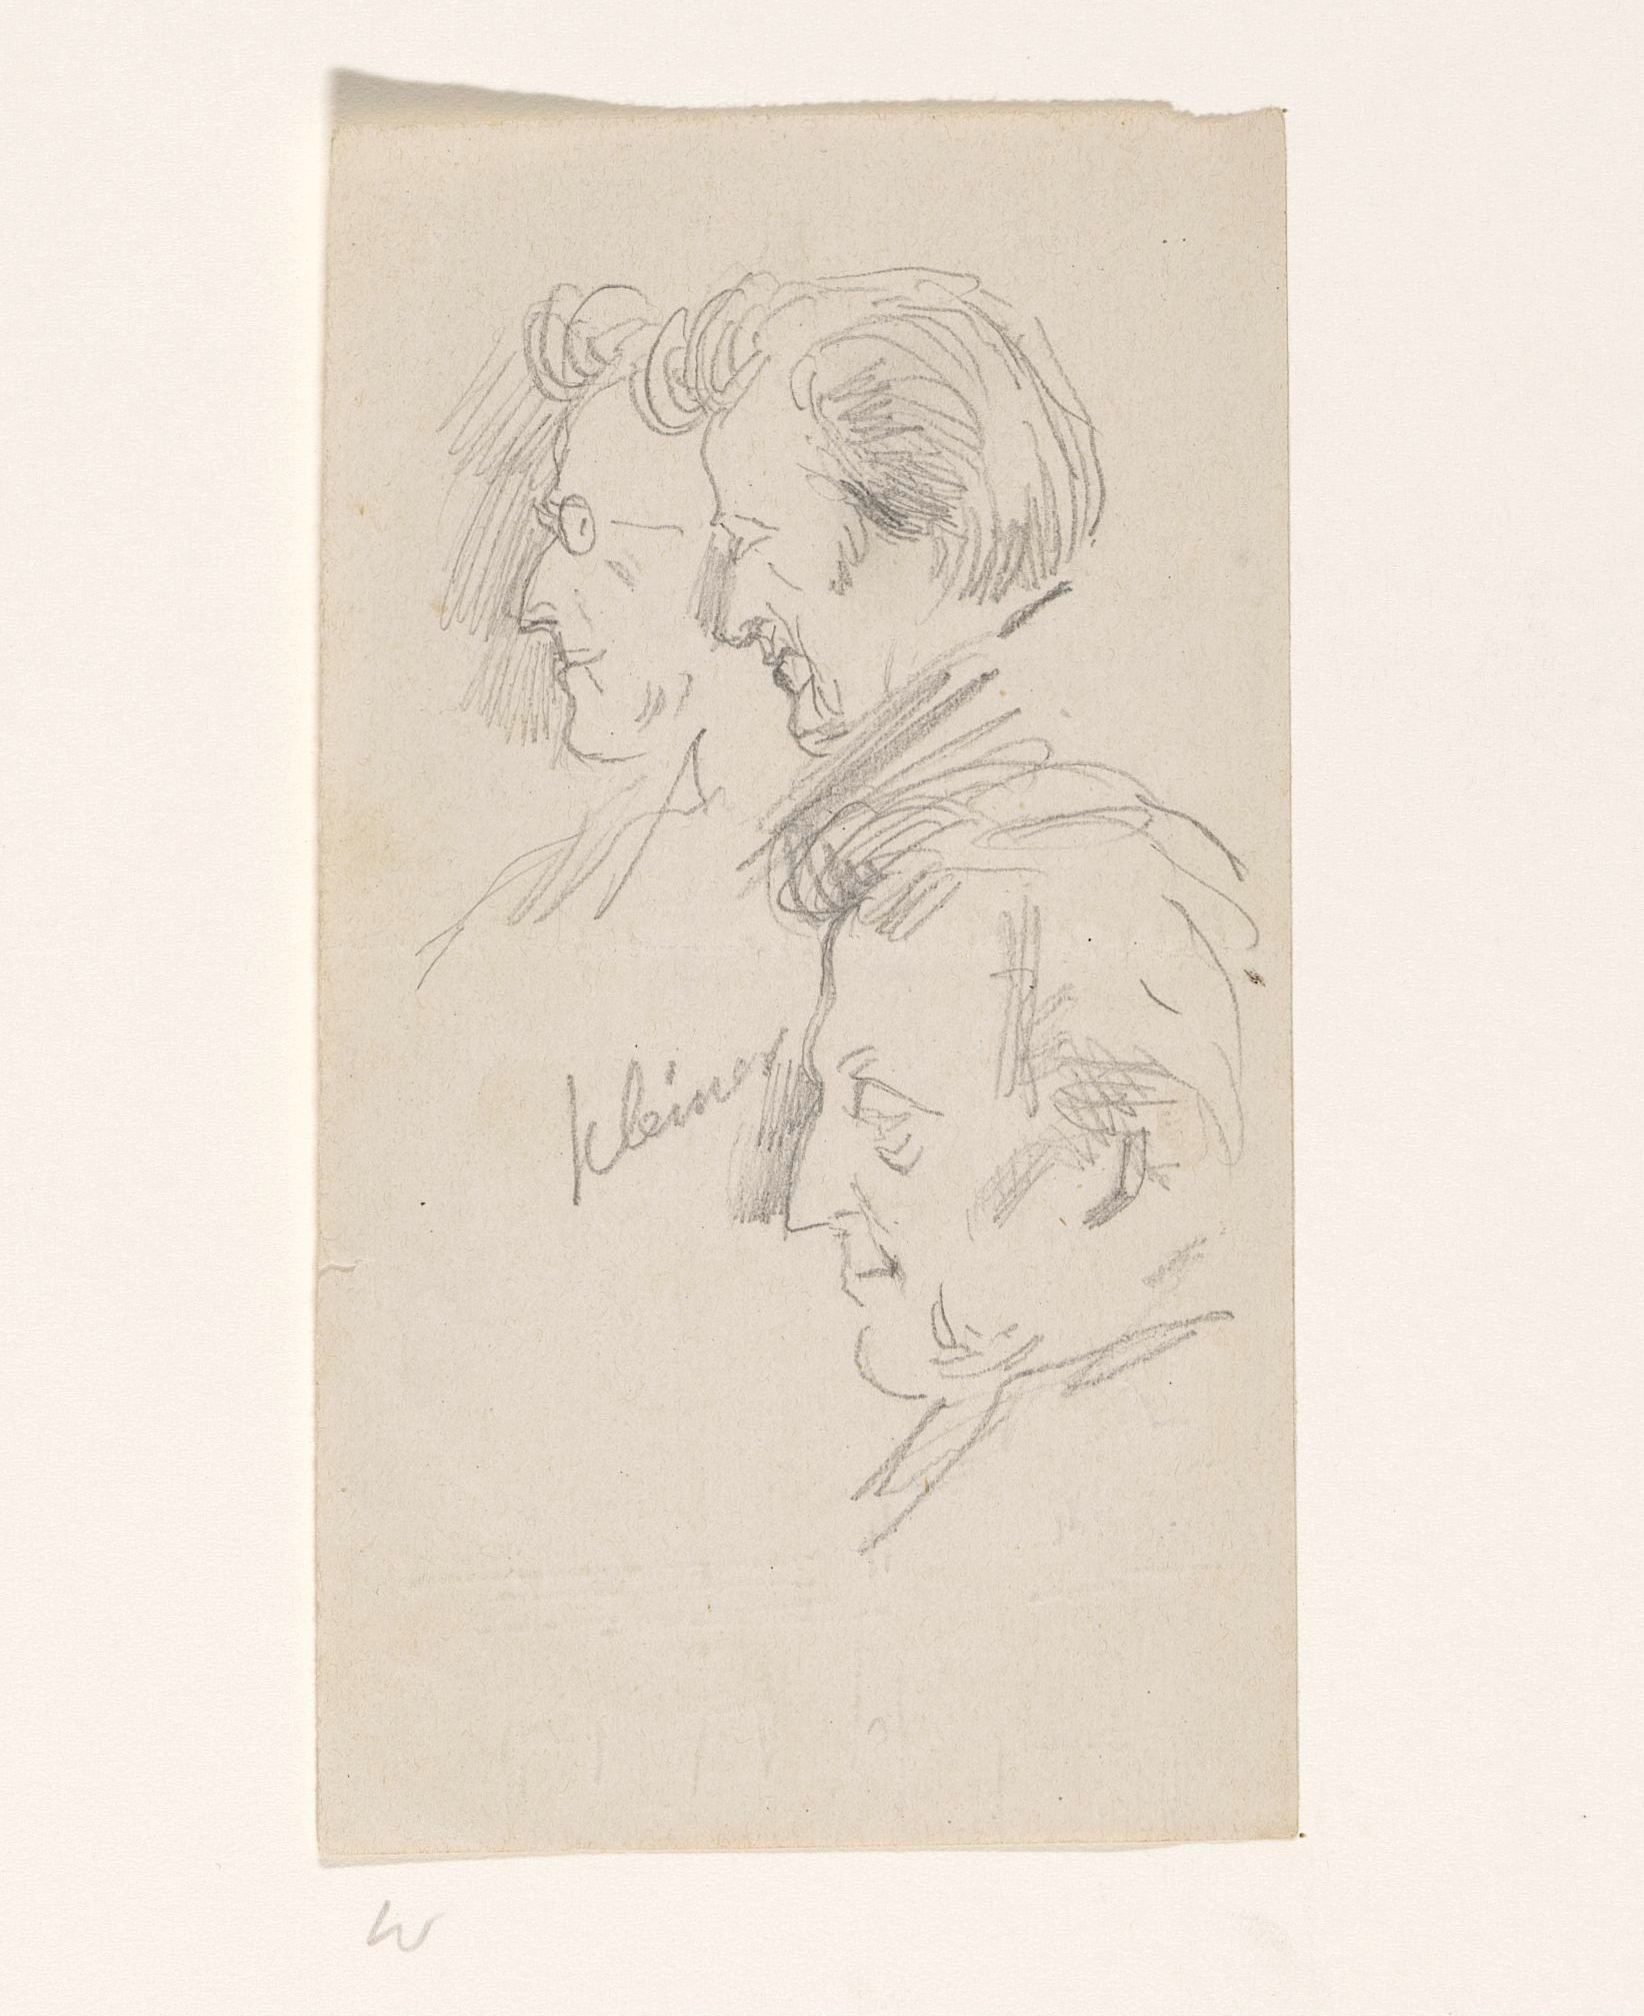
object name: drawing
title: Schets van mannen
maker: johan michaël schmidt crans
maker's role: draughtsman, print maker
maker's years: 1830-1907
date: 1875-1895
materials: paper, pencil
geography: netherlands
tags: historical persons not known by name, netherlands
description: Blad met een schets van drie onbekende manne, waarschijnlijk kamerleden. Mogelijk voorstudie voor politieke spotprent. Opschrift 'Kleiner'. Op de verso een schets van gebouwen.